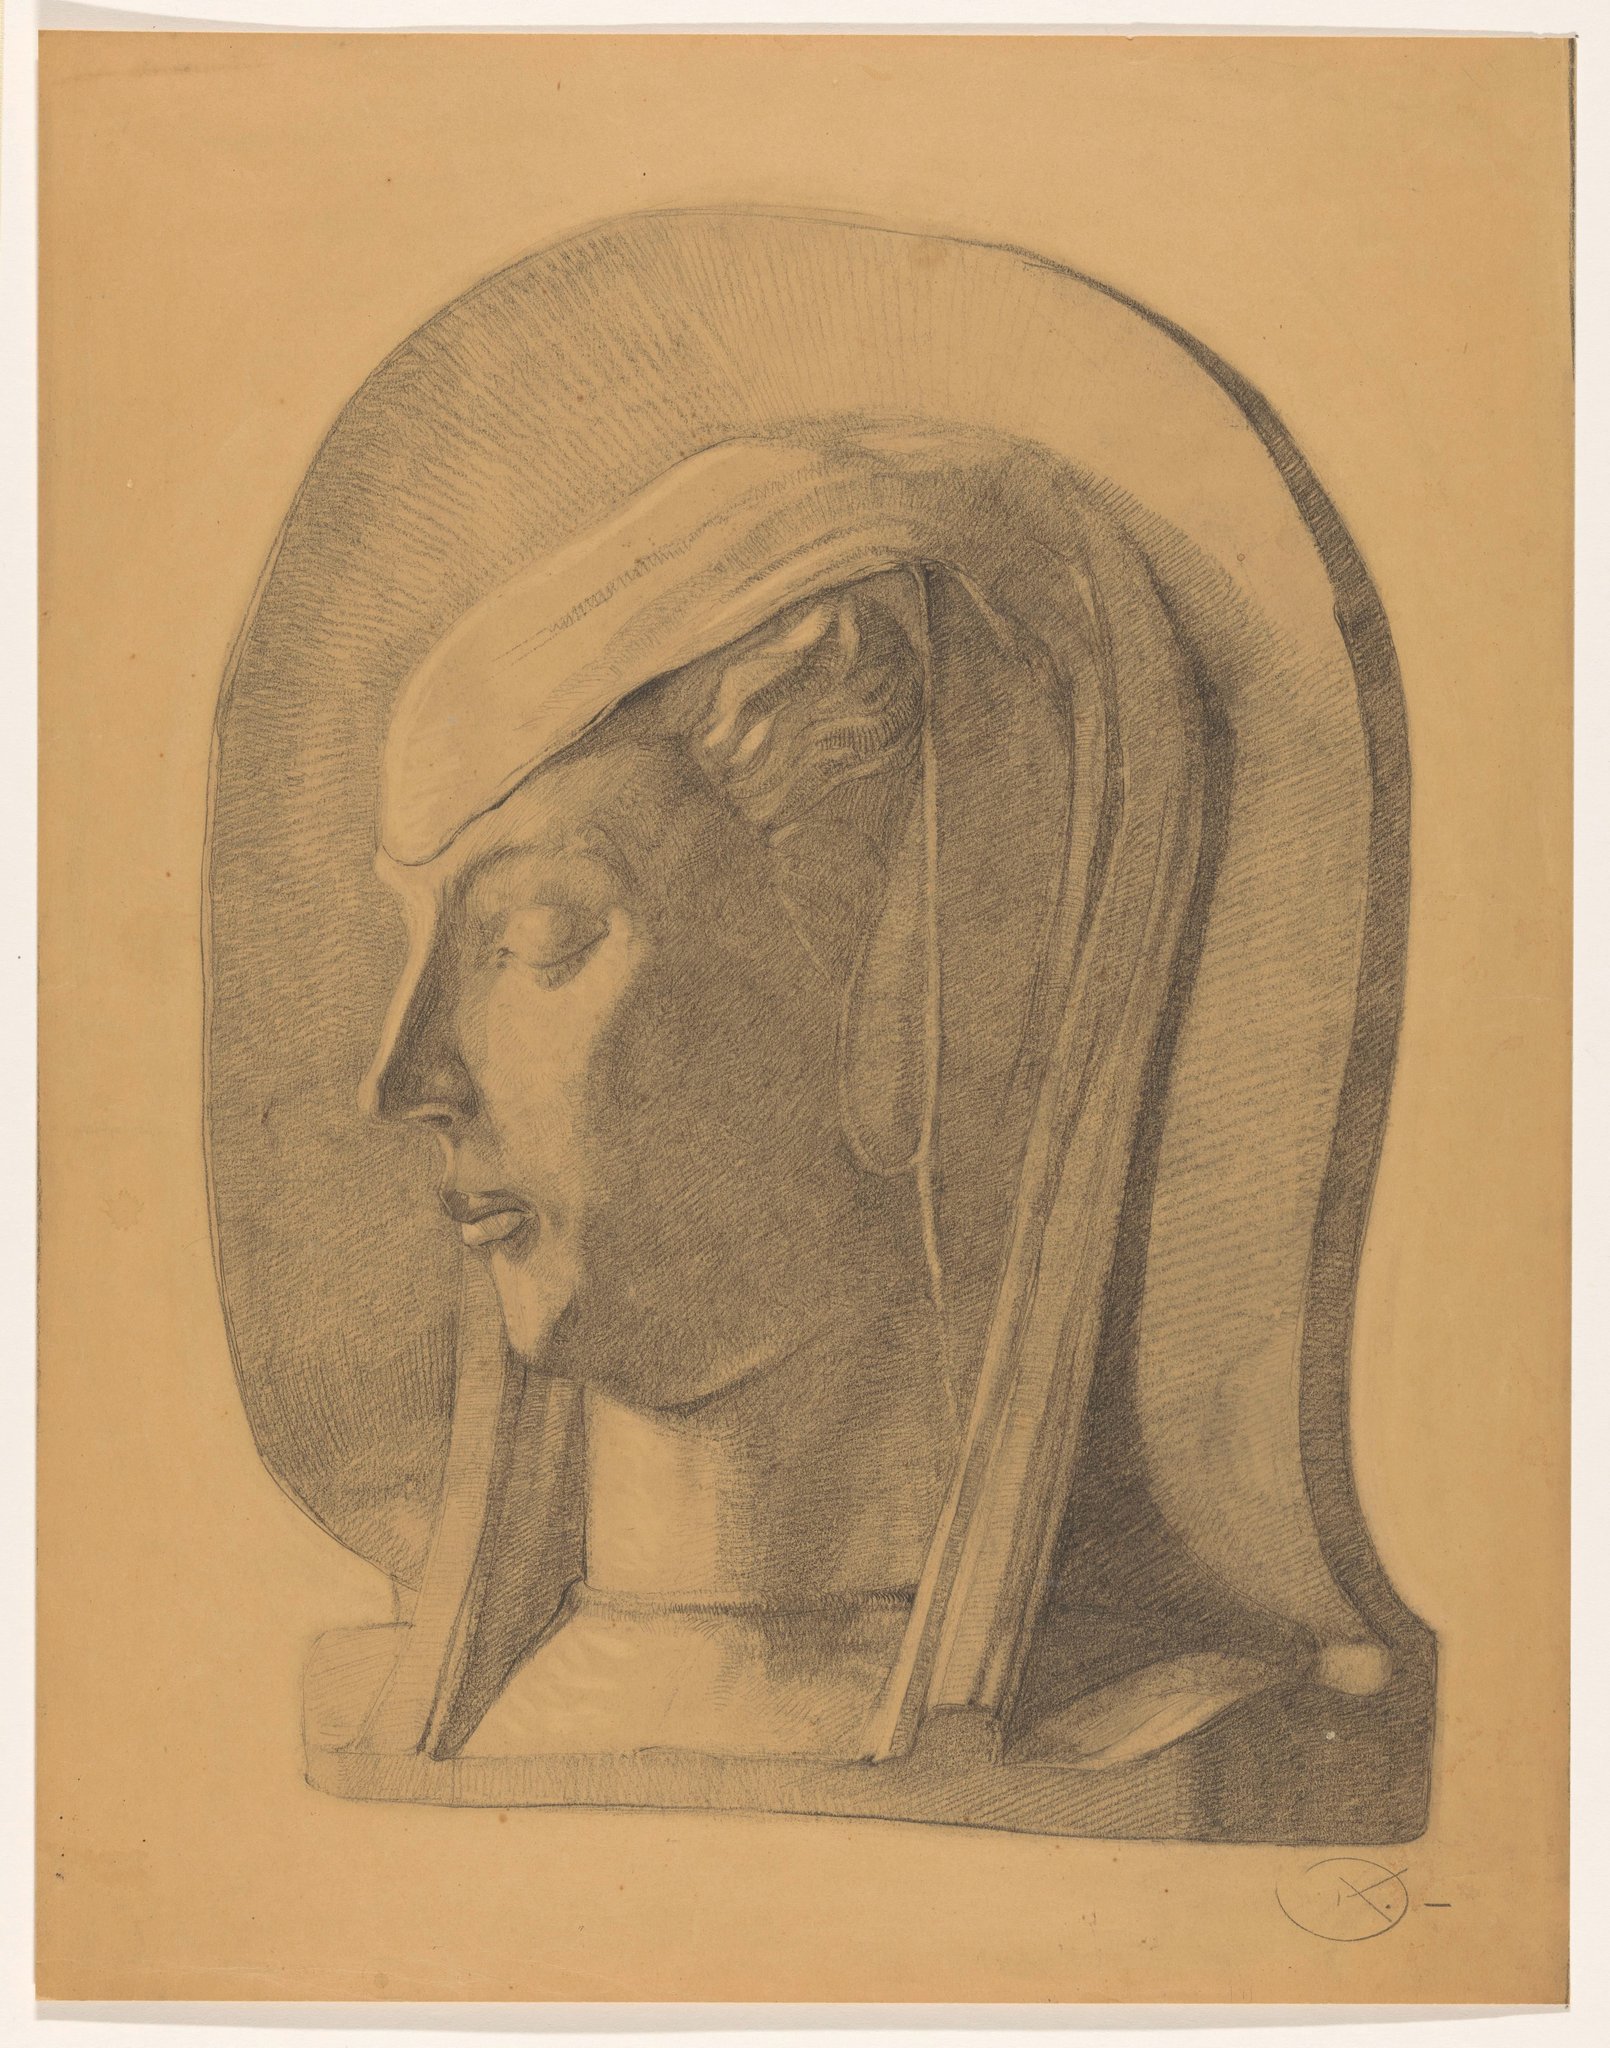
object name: drawing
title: Hoofd van een gesluierde vrouw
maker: dick ket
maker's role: draughtsman, print maker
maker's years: 1902-1940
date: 1912-1940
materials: chalk, paper, pencil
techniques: brush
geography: ede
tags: head (human) - aa - female human figure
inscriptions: collector's mark: Lugt 2228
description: Deze tekening is mogelijk vervaardigd naar een houten reliëf.